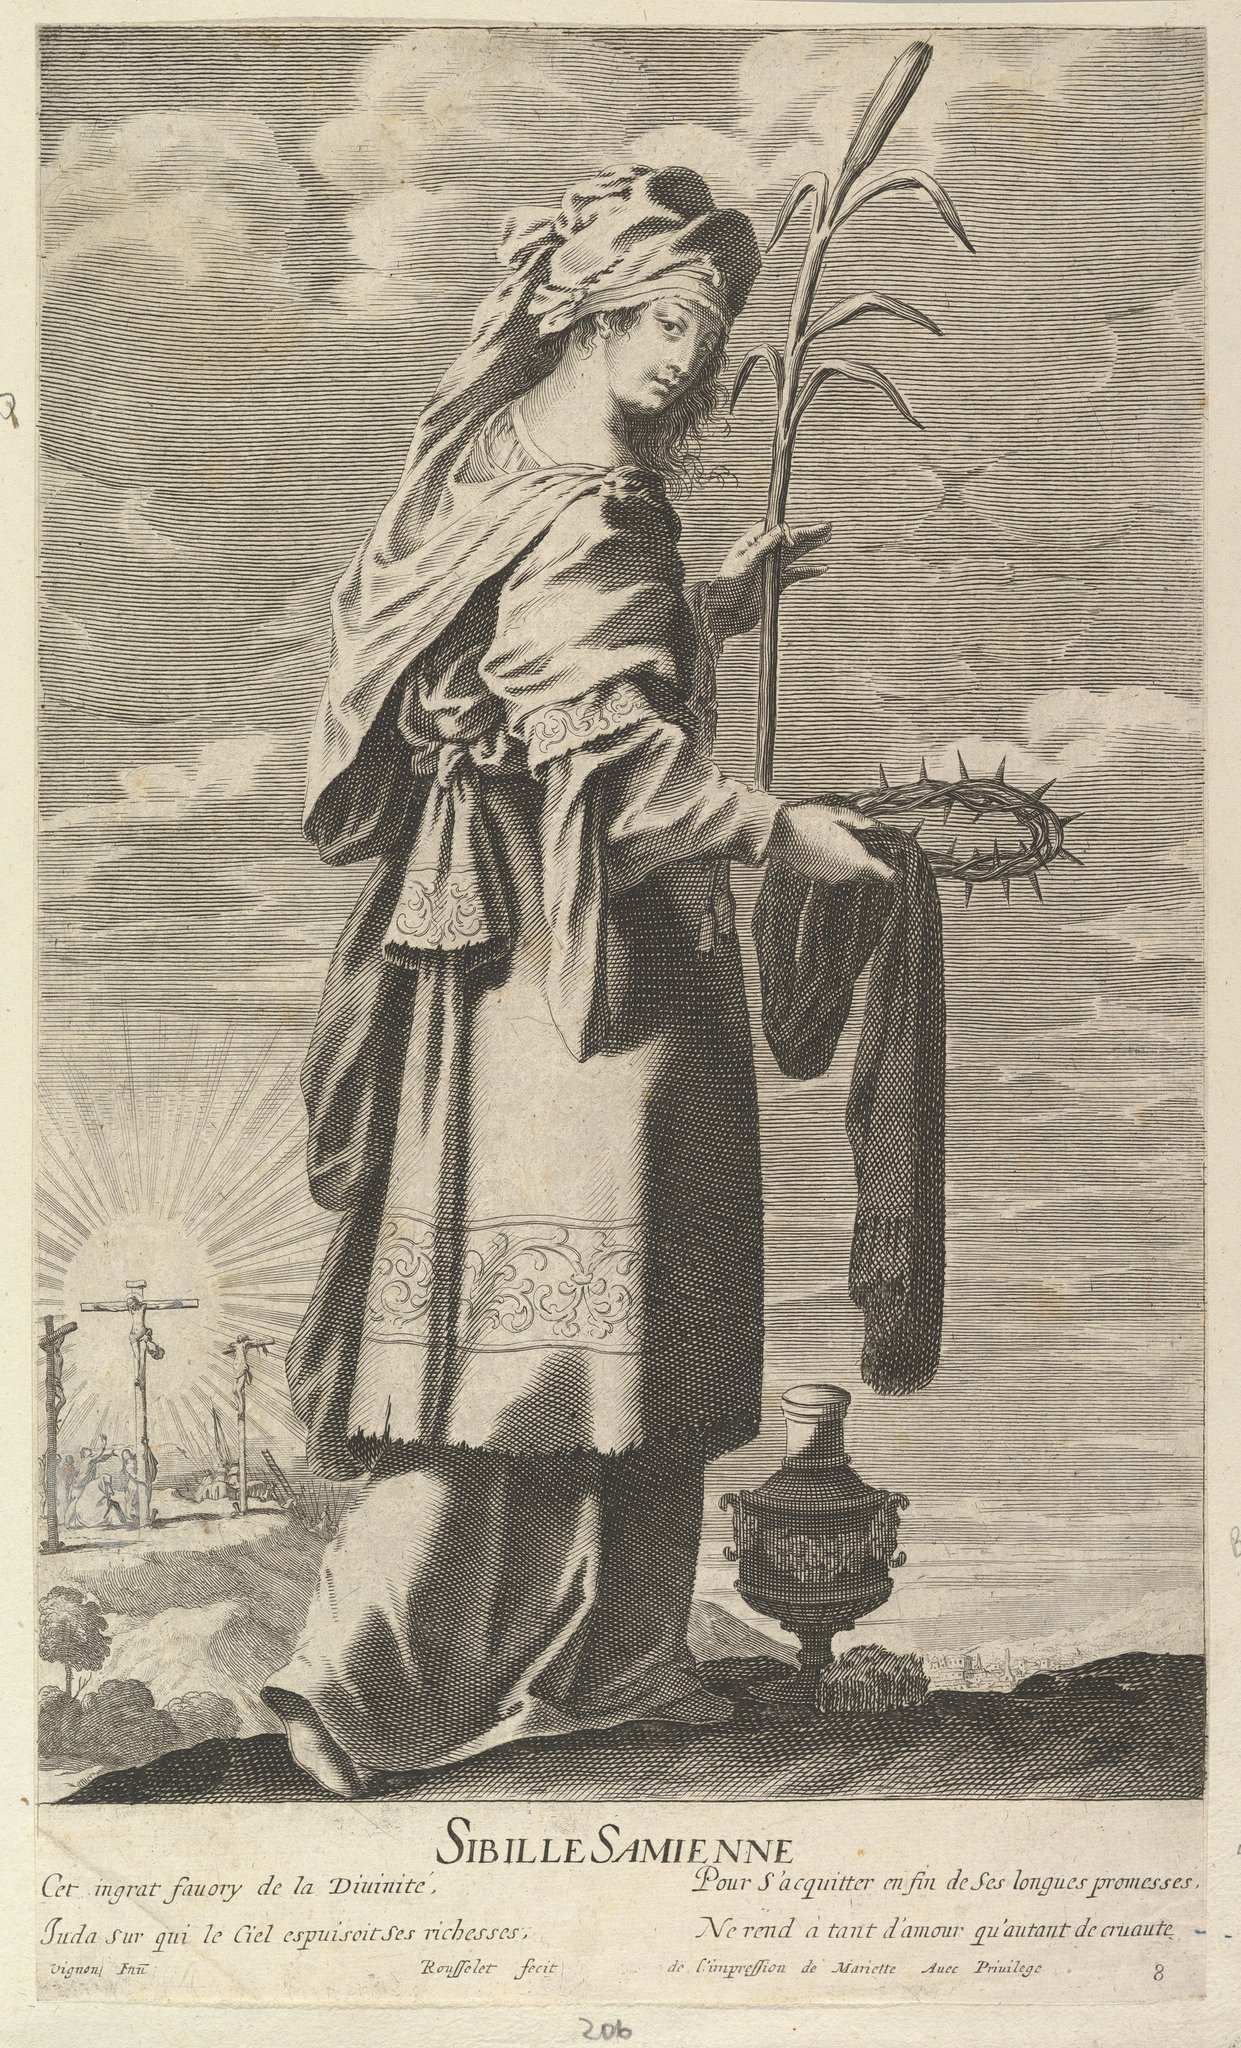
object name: print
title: Sibylle Samienne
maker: gilles rousselet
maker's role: artist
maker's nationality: french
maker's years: 1614-1686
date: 1635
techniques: engraving, etching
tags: women,jesus,crucifixion